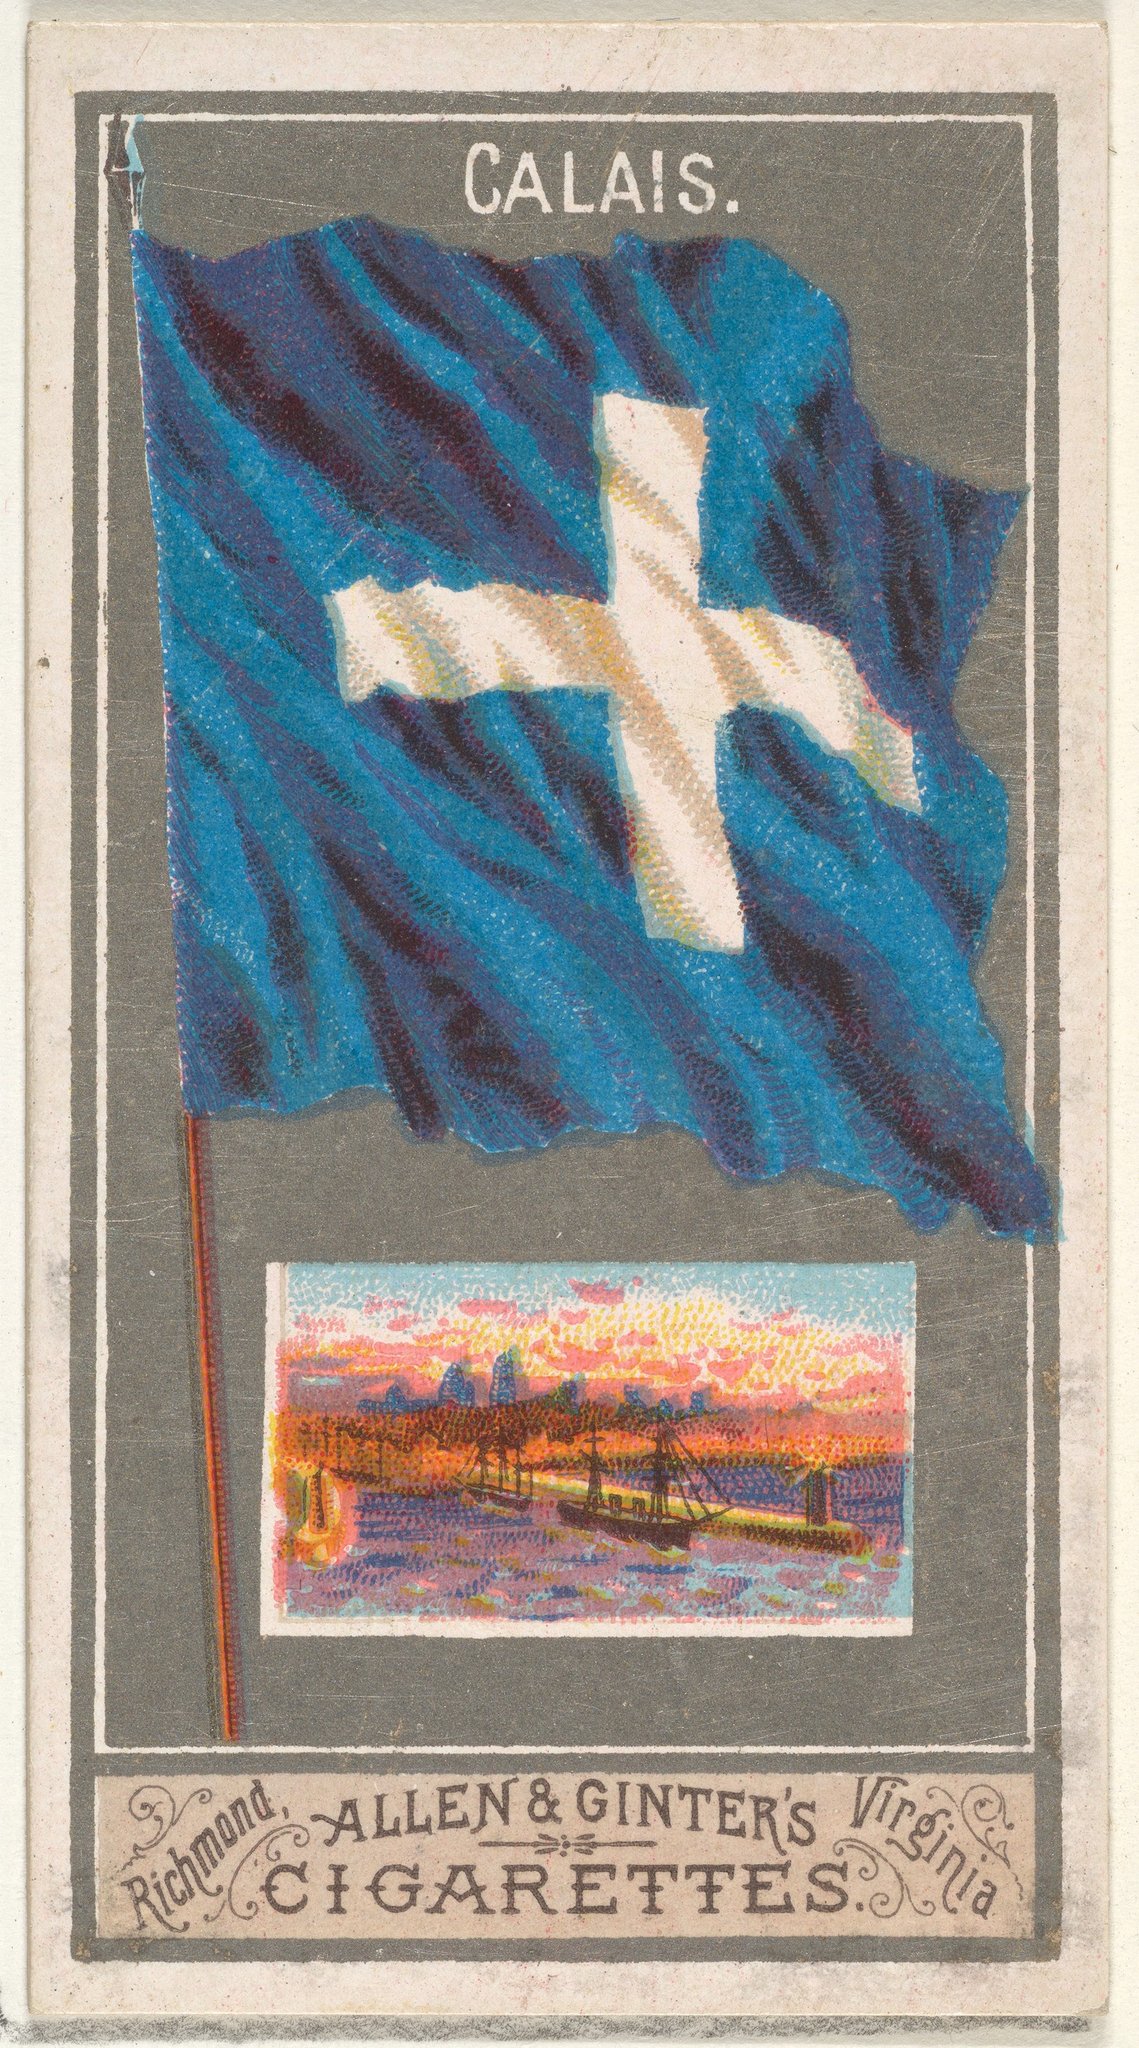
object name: print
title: Calais, from the City Flags series (N6) for Allen & Ginter Cigarettes Brands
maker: allen & ginter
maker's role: publisher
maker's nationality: american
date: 1887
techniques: color lithograph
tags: flags